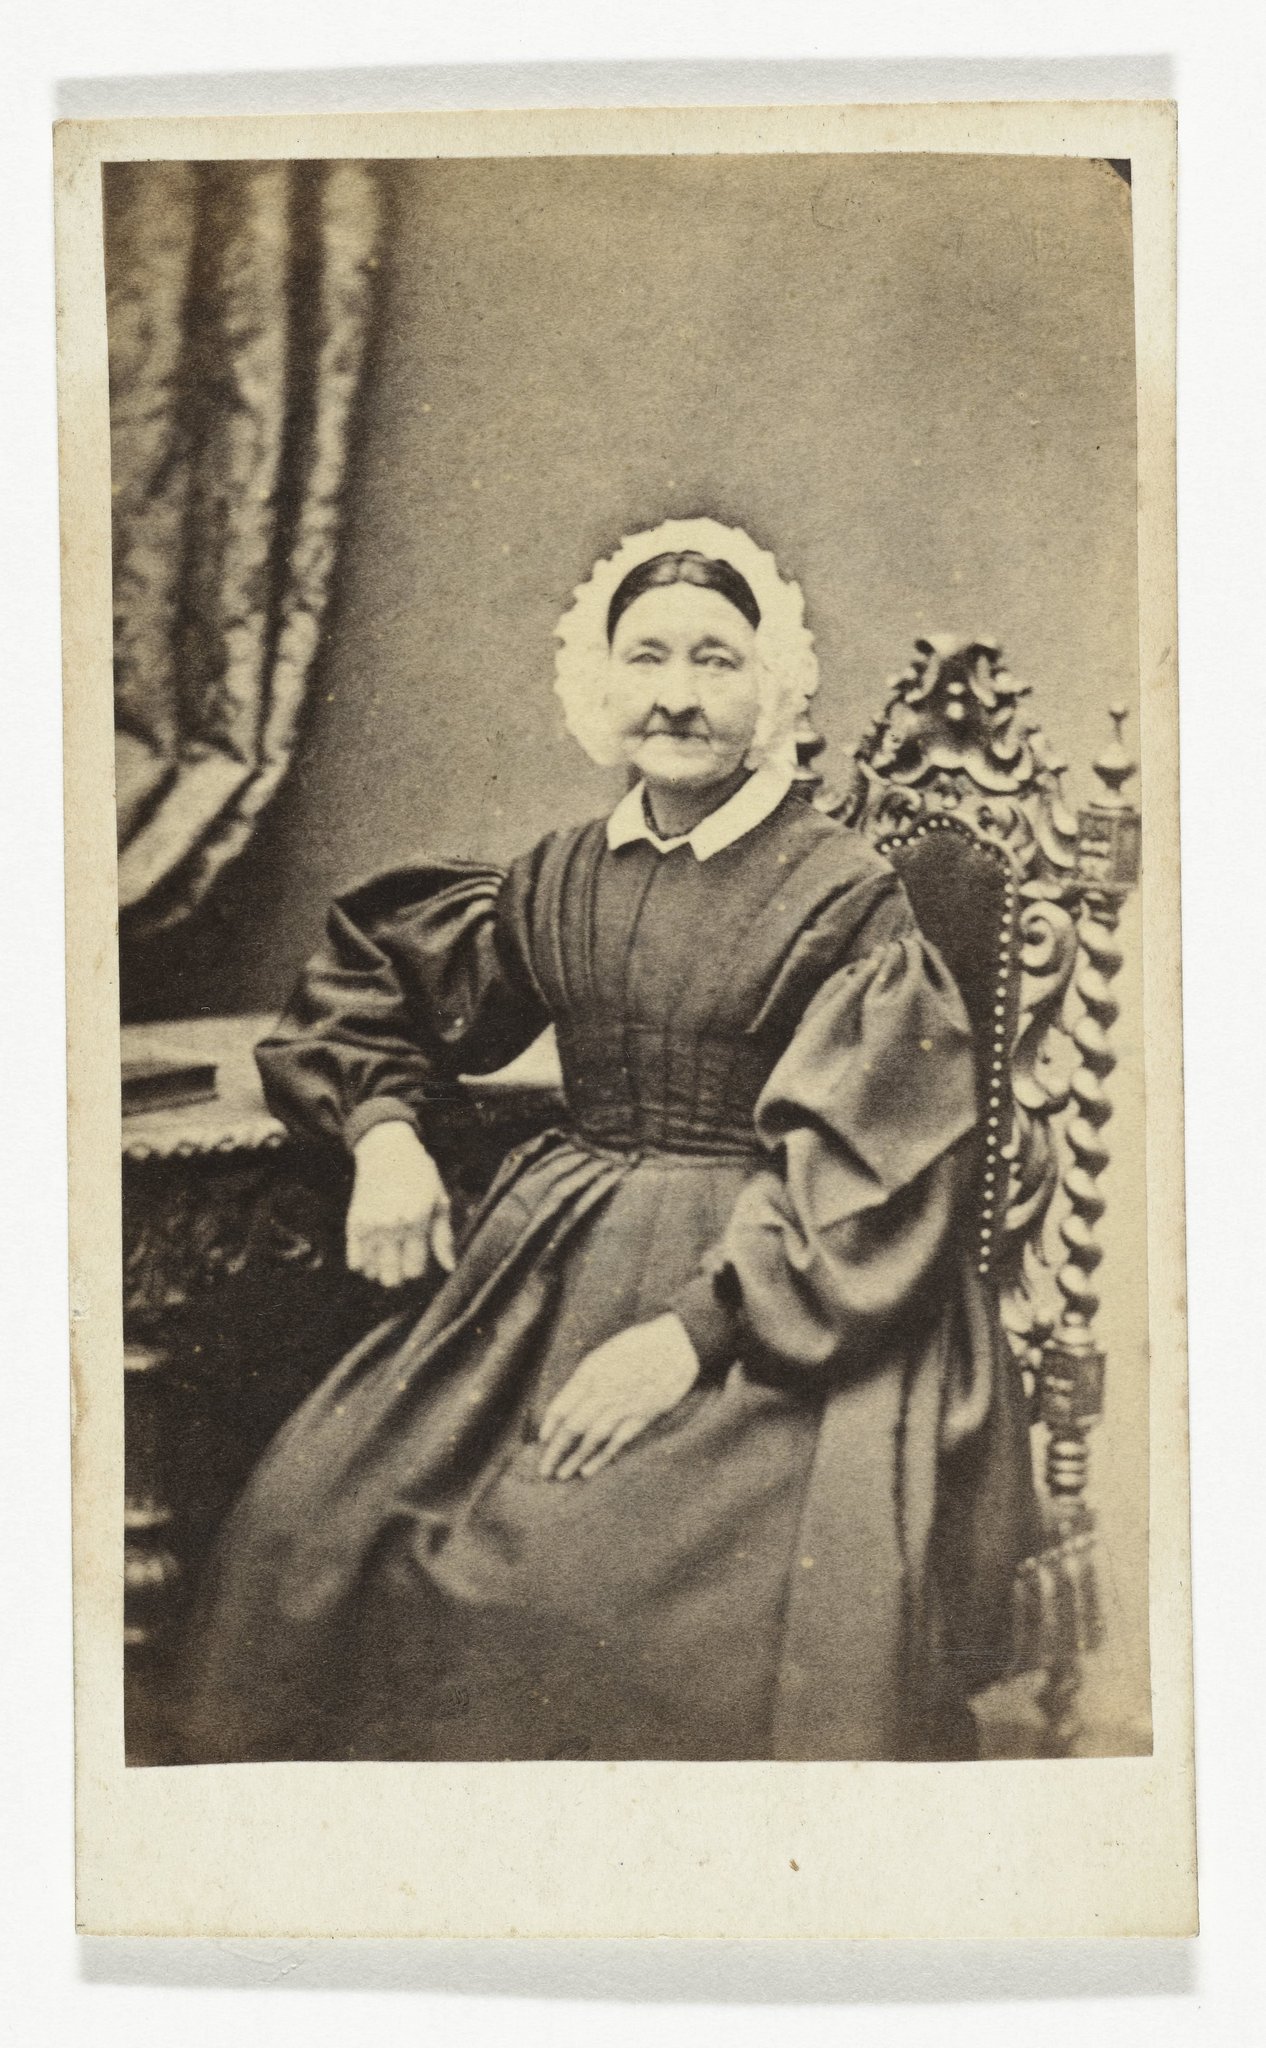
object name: photograph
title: Portret van een onbekende vrouw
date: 1865-1900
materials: cardboard, photographic support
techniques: albumen print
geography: netherlands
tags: historical persons not known by name - bb - woman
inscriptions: inscription: ‘ENGELSCH / Photographisch Etablissement / Kalverstraat bij de Munt / D. 39 / Reproductiën’